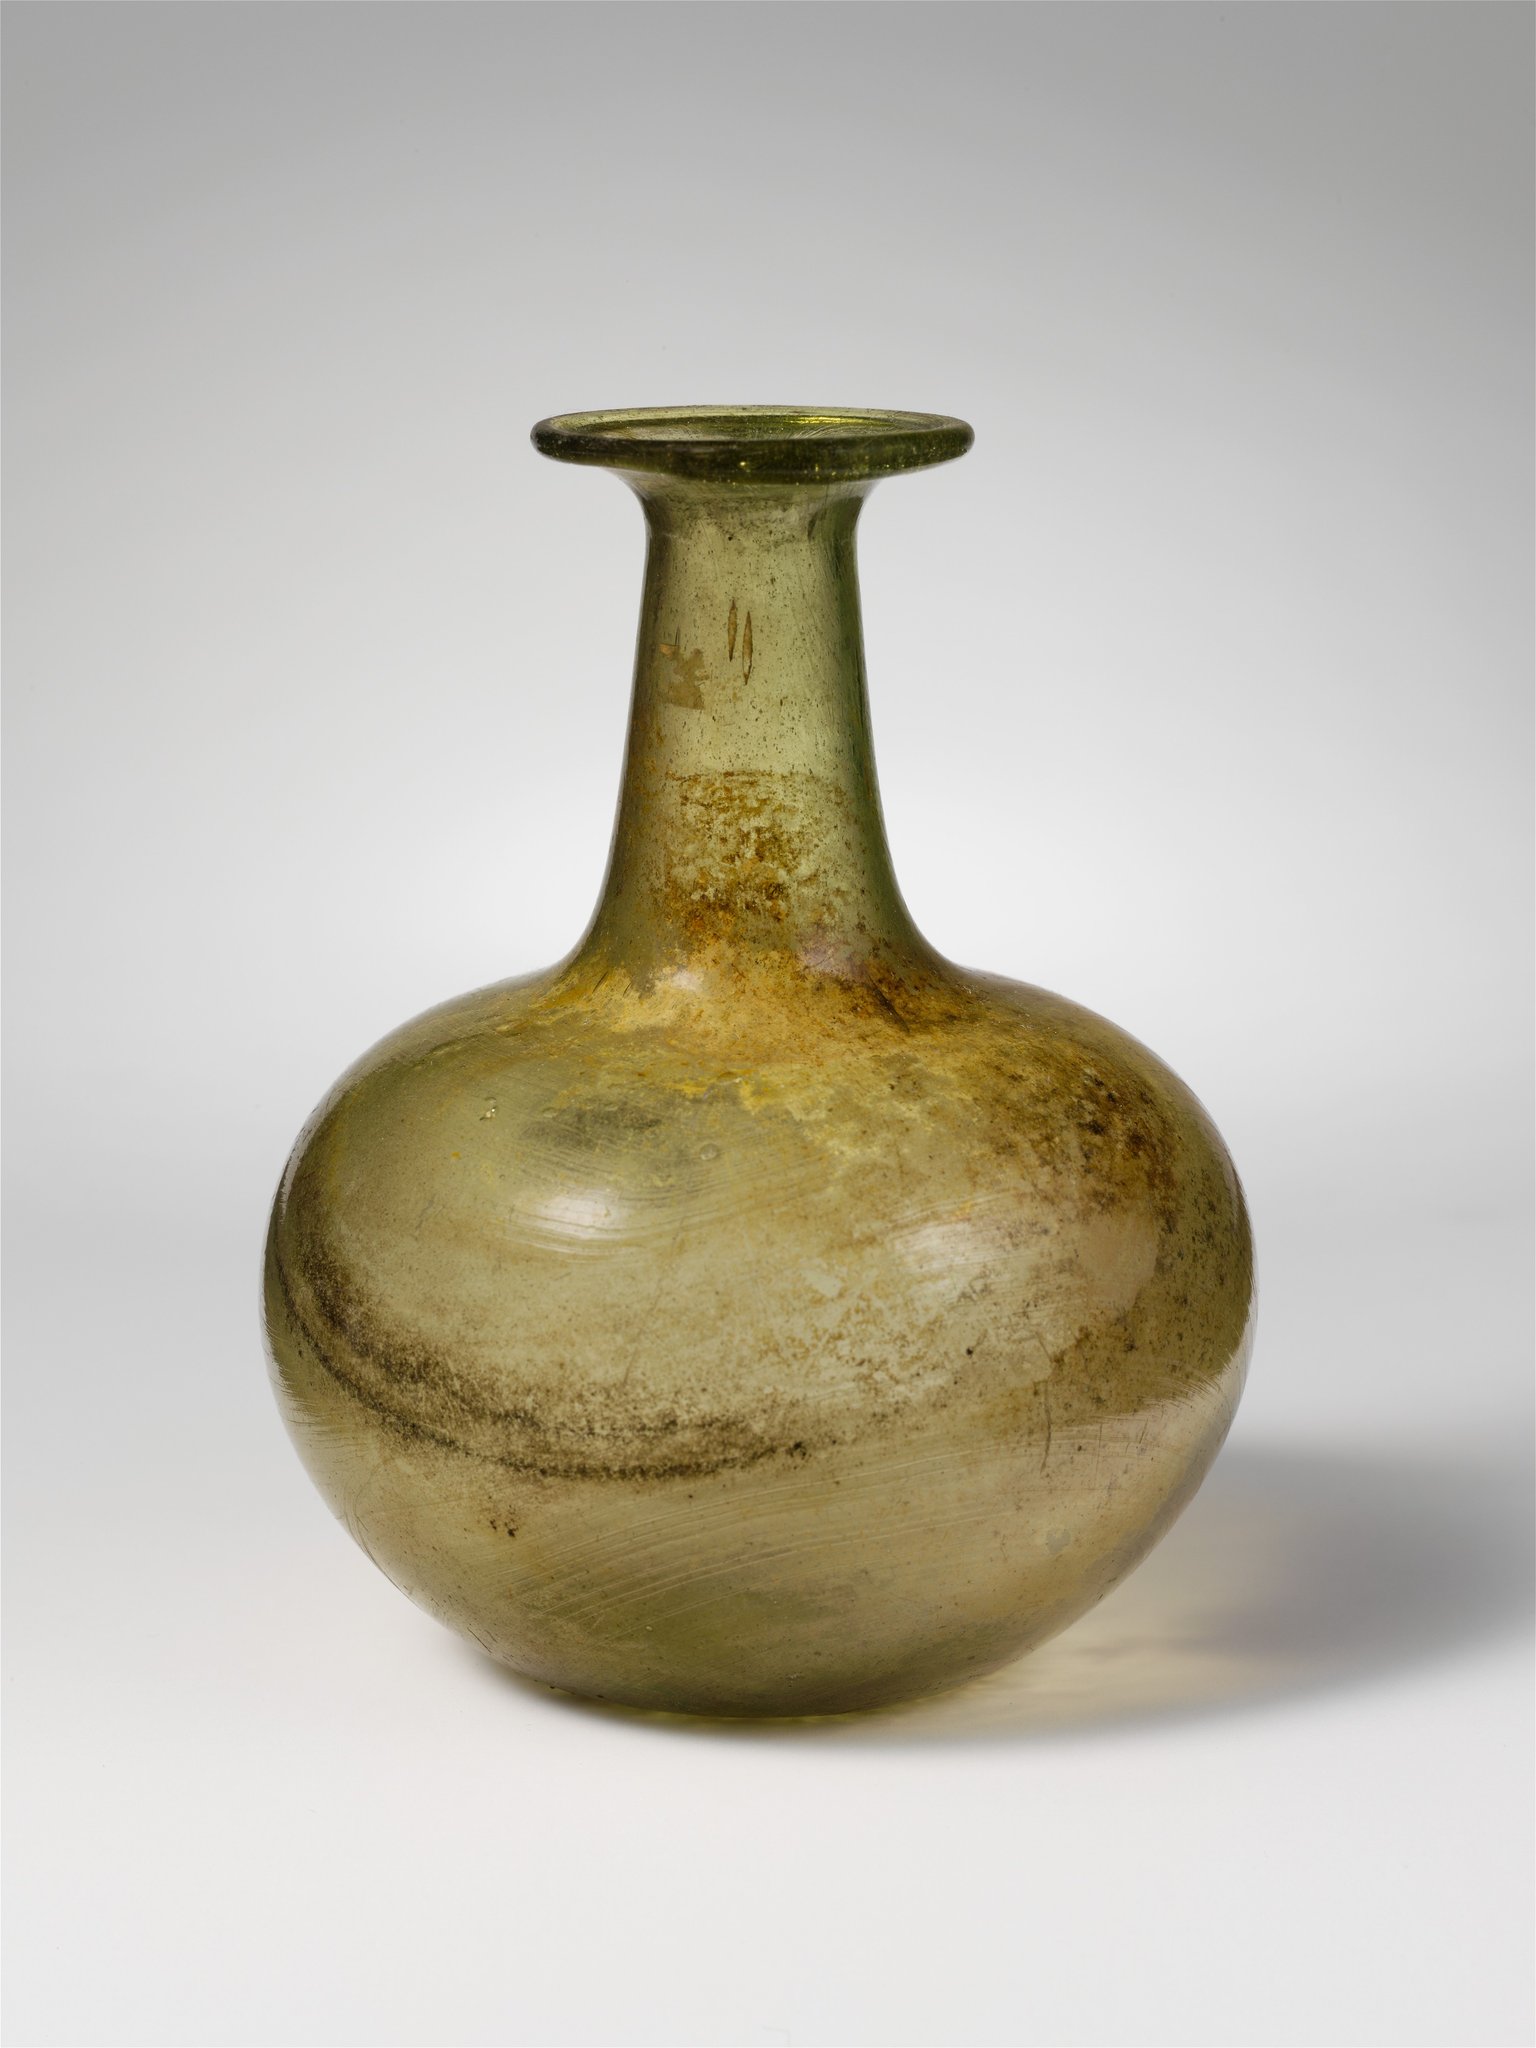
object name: bottle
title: Glass bottle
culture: roman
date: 101-300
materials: glass